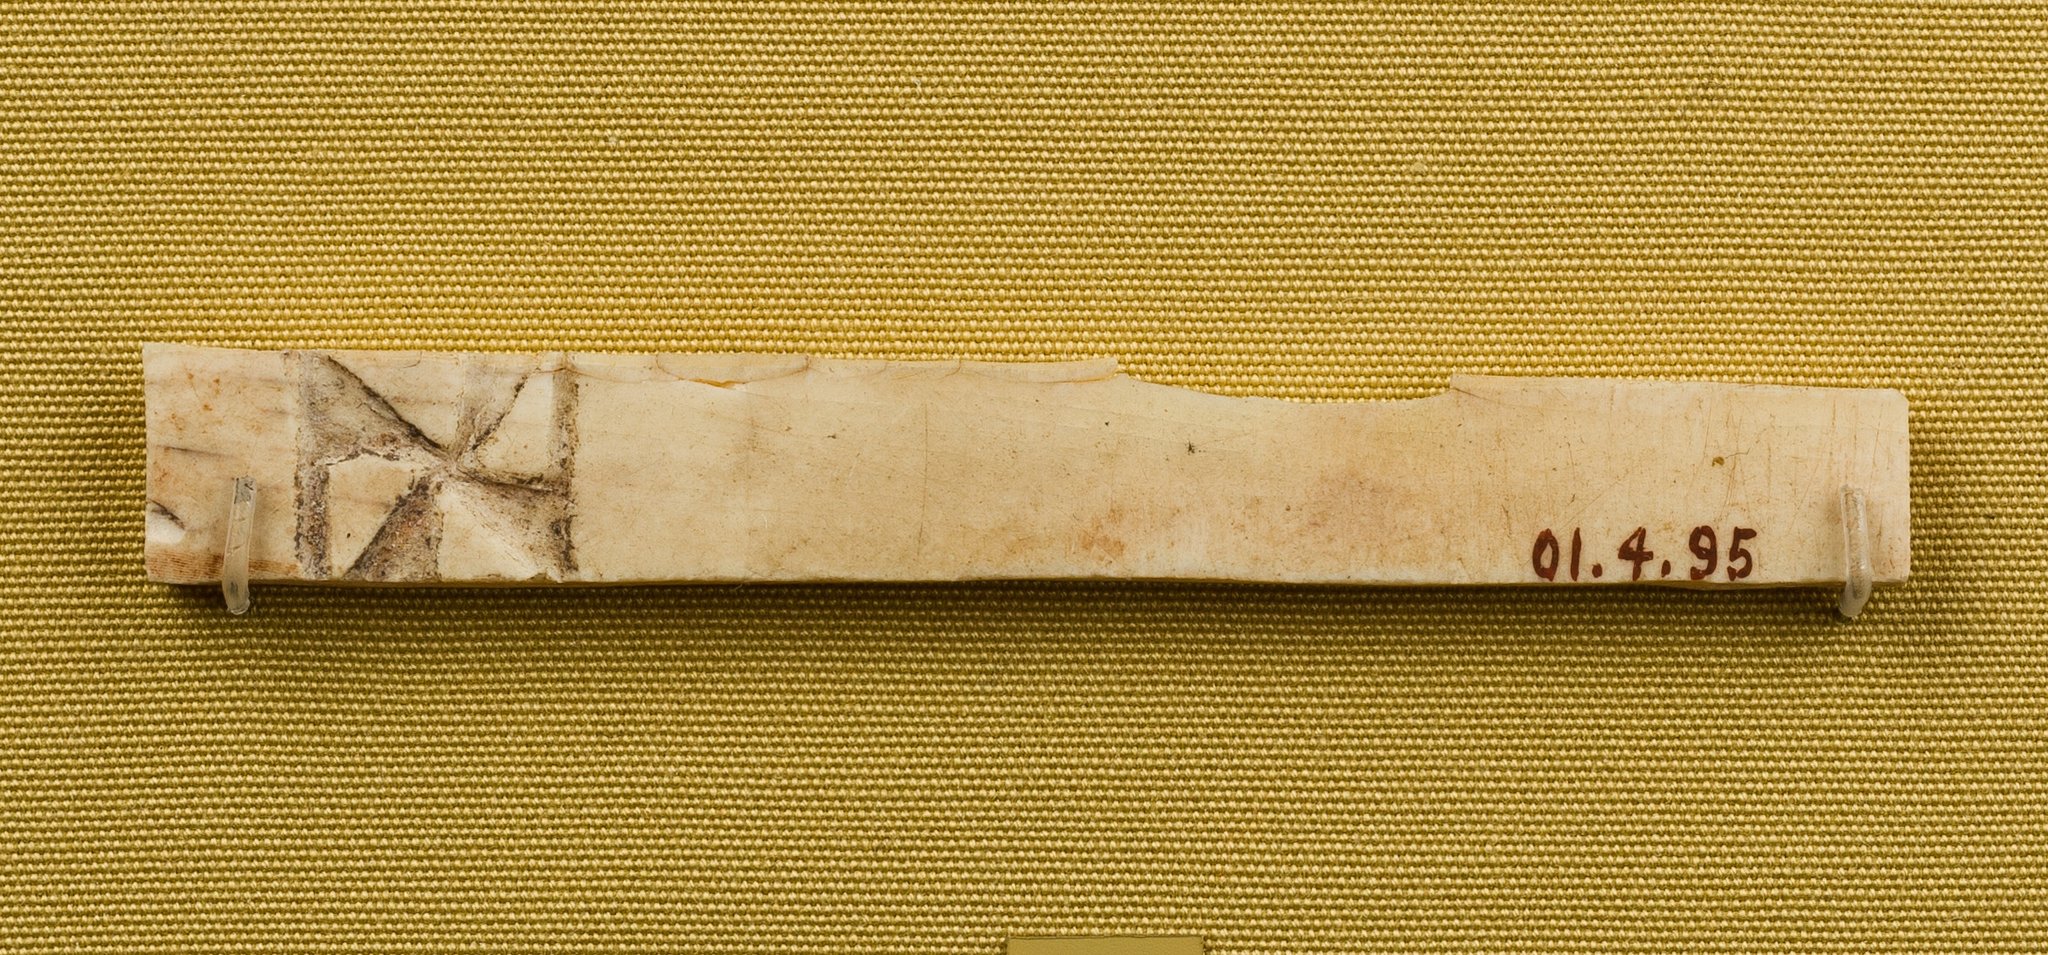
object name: inlay, from a box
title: Box inlay with a geometric pattern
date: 3100-2900 BCE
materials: ivory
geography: egypt